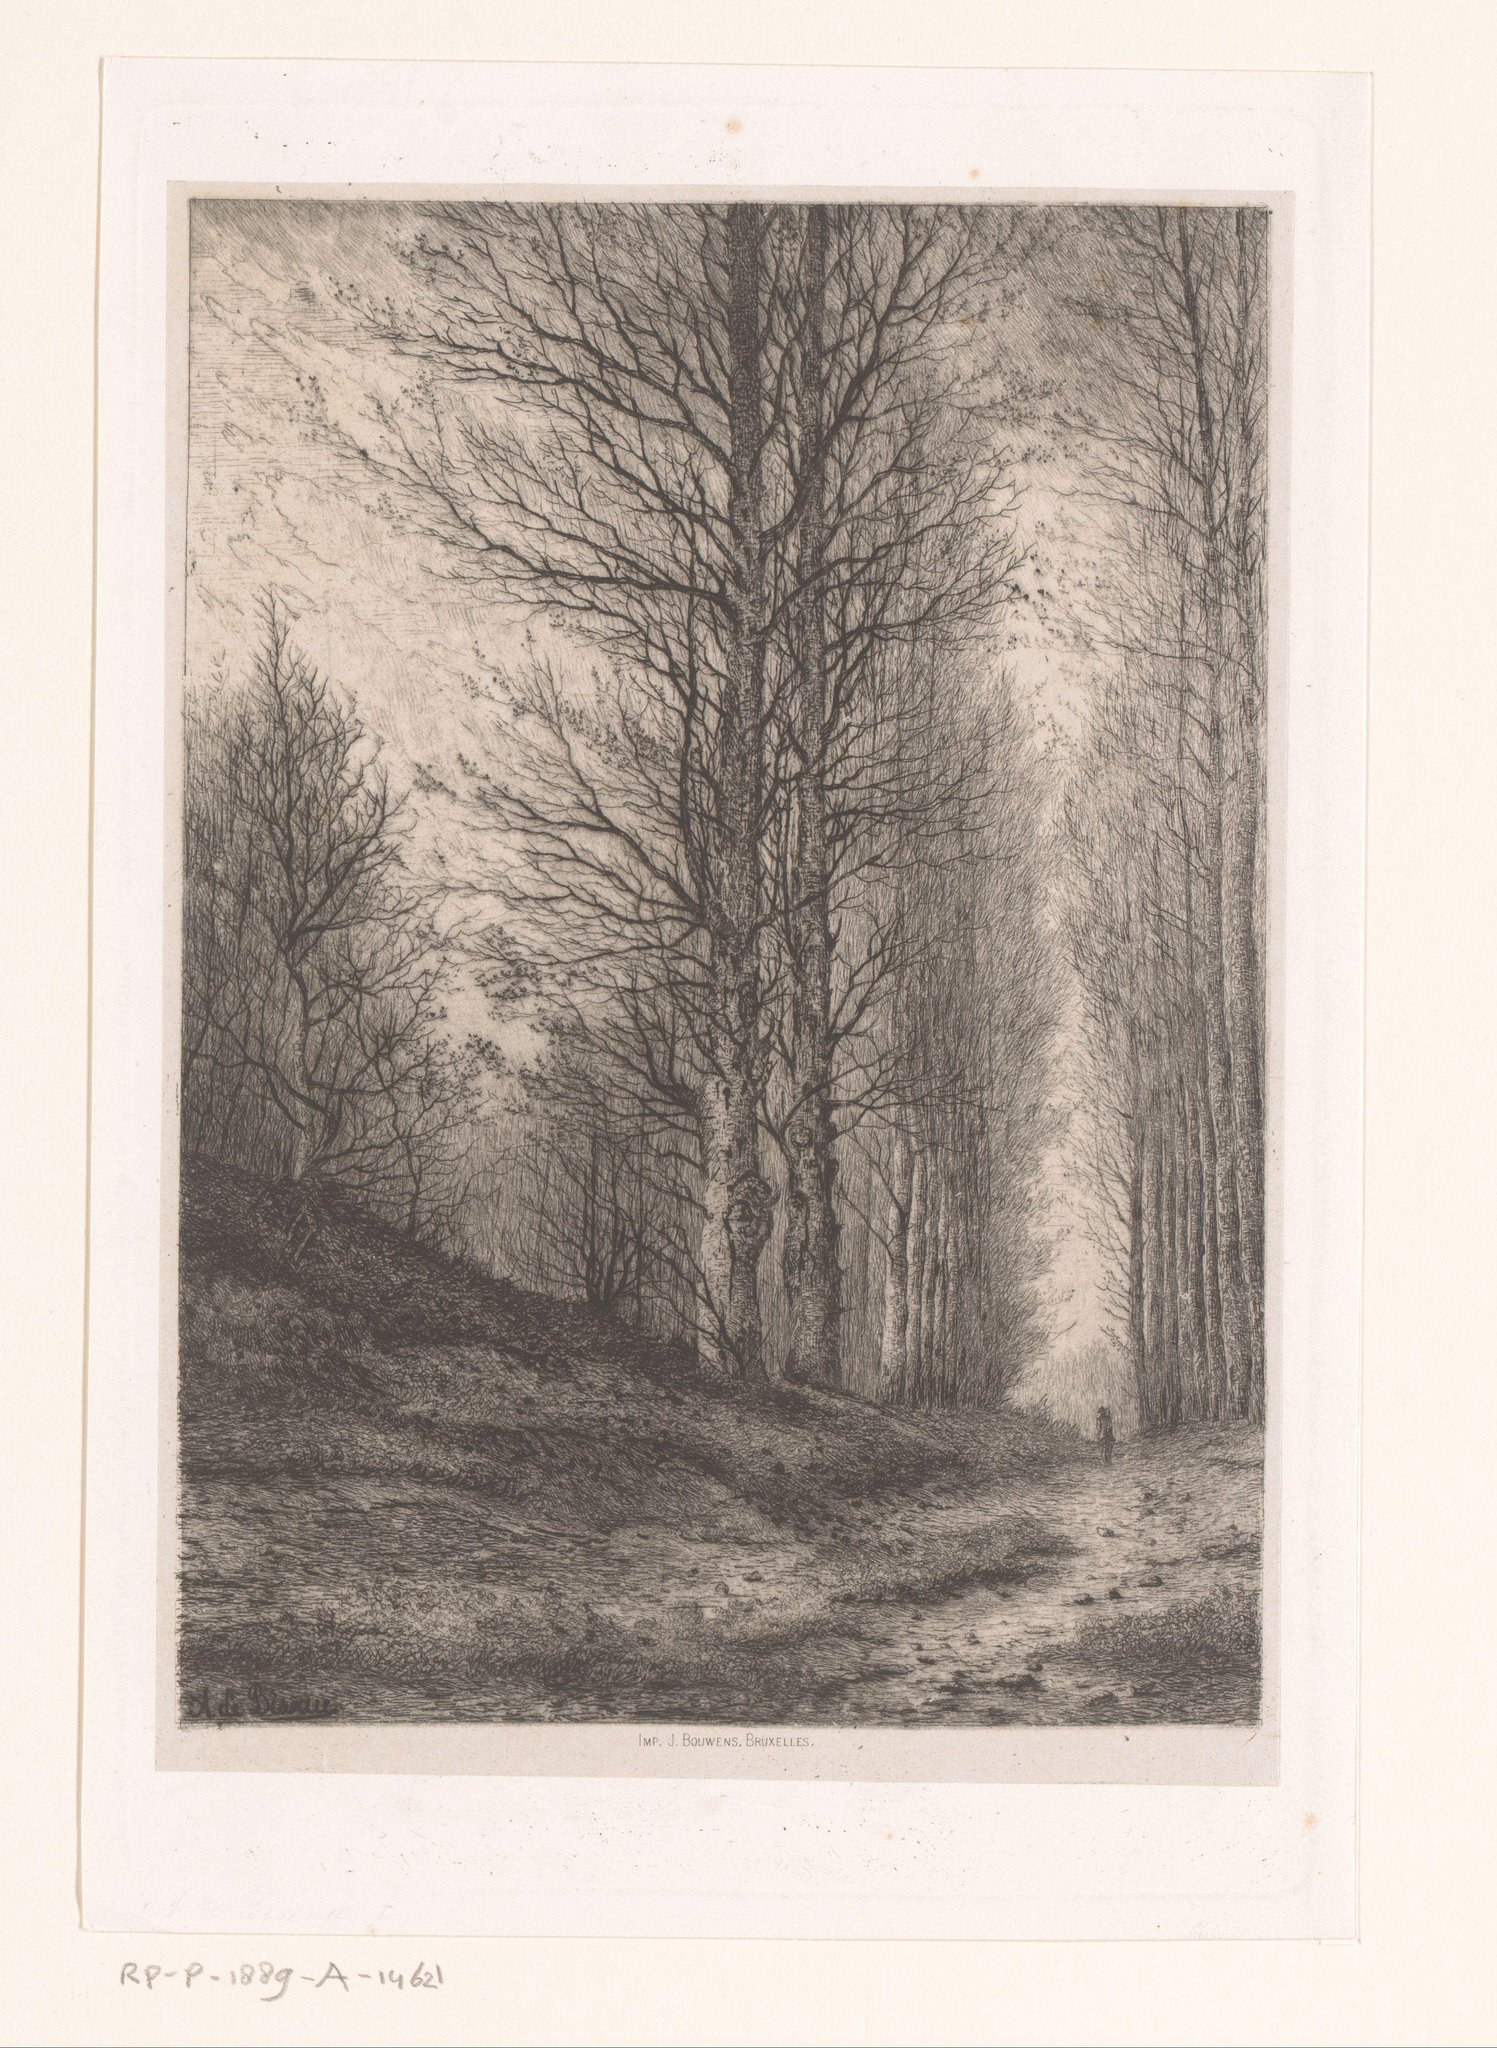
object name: print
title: Boslaan met ruiter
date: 1873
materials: paper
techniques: etching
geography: brussels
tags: horse throwing rider, trees: beech, forest path or lane, autumn, fall, 'autumnus'; 'autunno' (ripa)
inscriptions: collector's mark: Lugt 2228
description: Prent uit: Album du Journal des Beaux-Arts. Antwerpen, s.n., 1873.